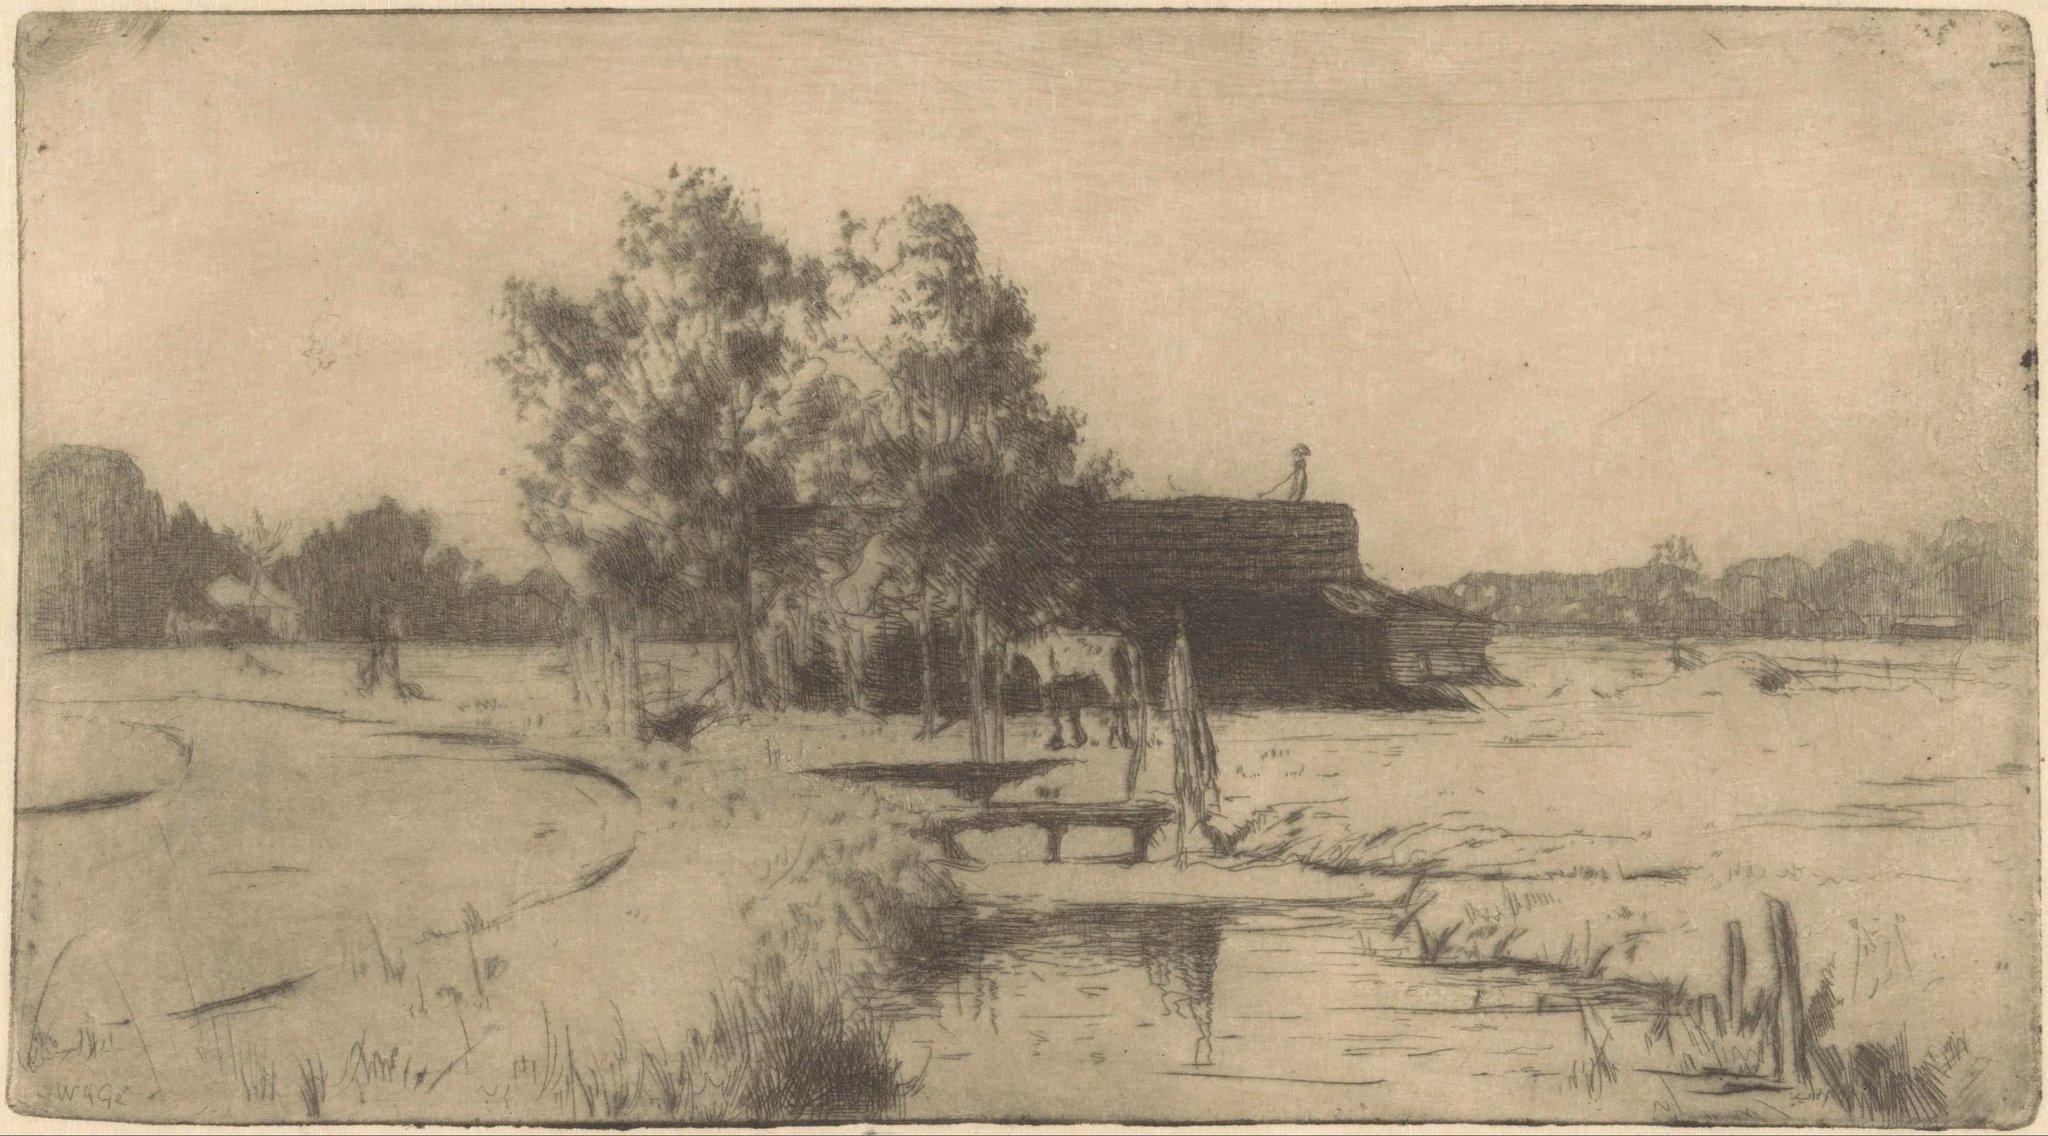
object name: print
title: Stal in de Binckhorst in Den Haag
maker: willem adrianus grondhout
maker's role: draughtsman, painter, print maker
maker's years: 1878-1934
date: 1914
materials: paper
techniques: etching, intaglio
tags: horse, stall, stable, small canal, ditch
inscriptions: collector's mark: Lugt 2228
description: Een stal en bomen aan een sloot. Voor de stal een paard.